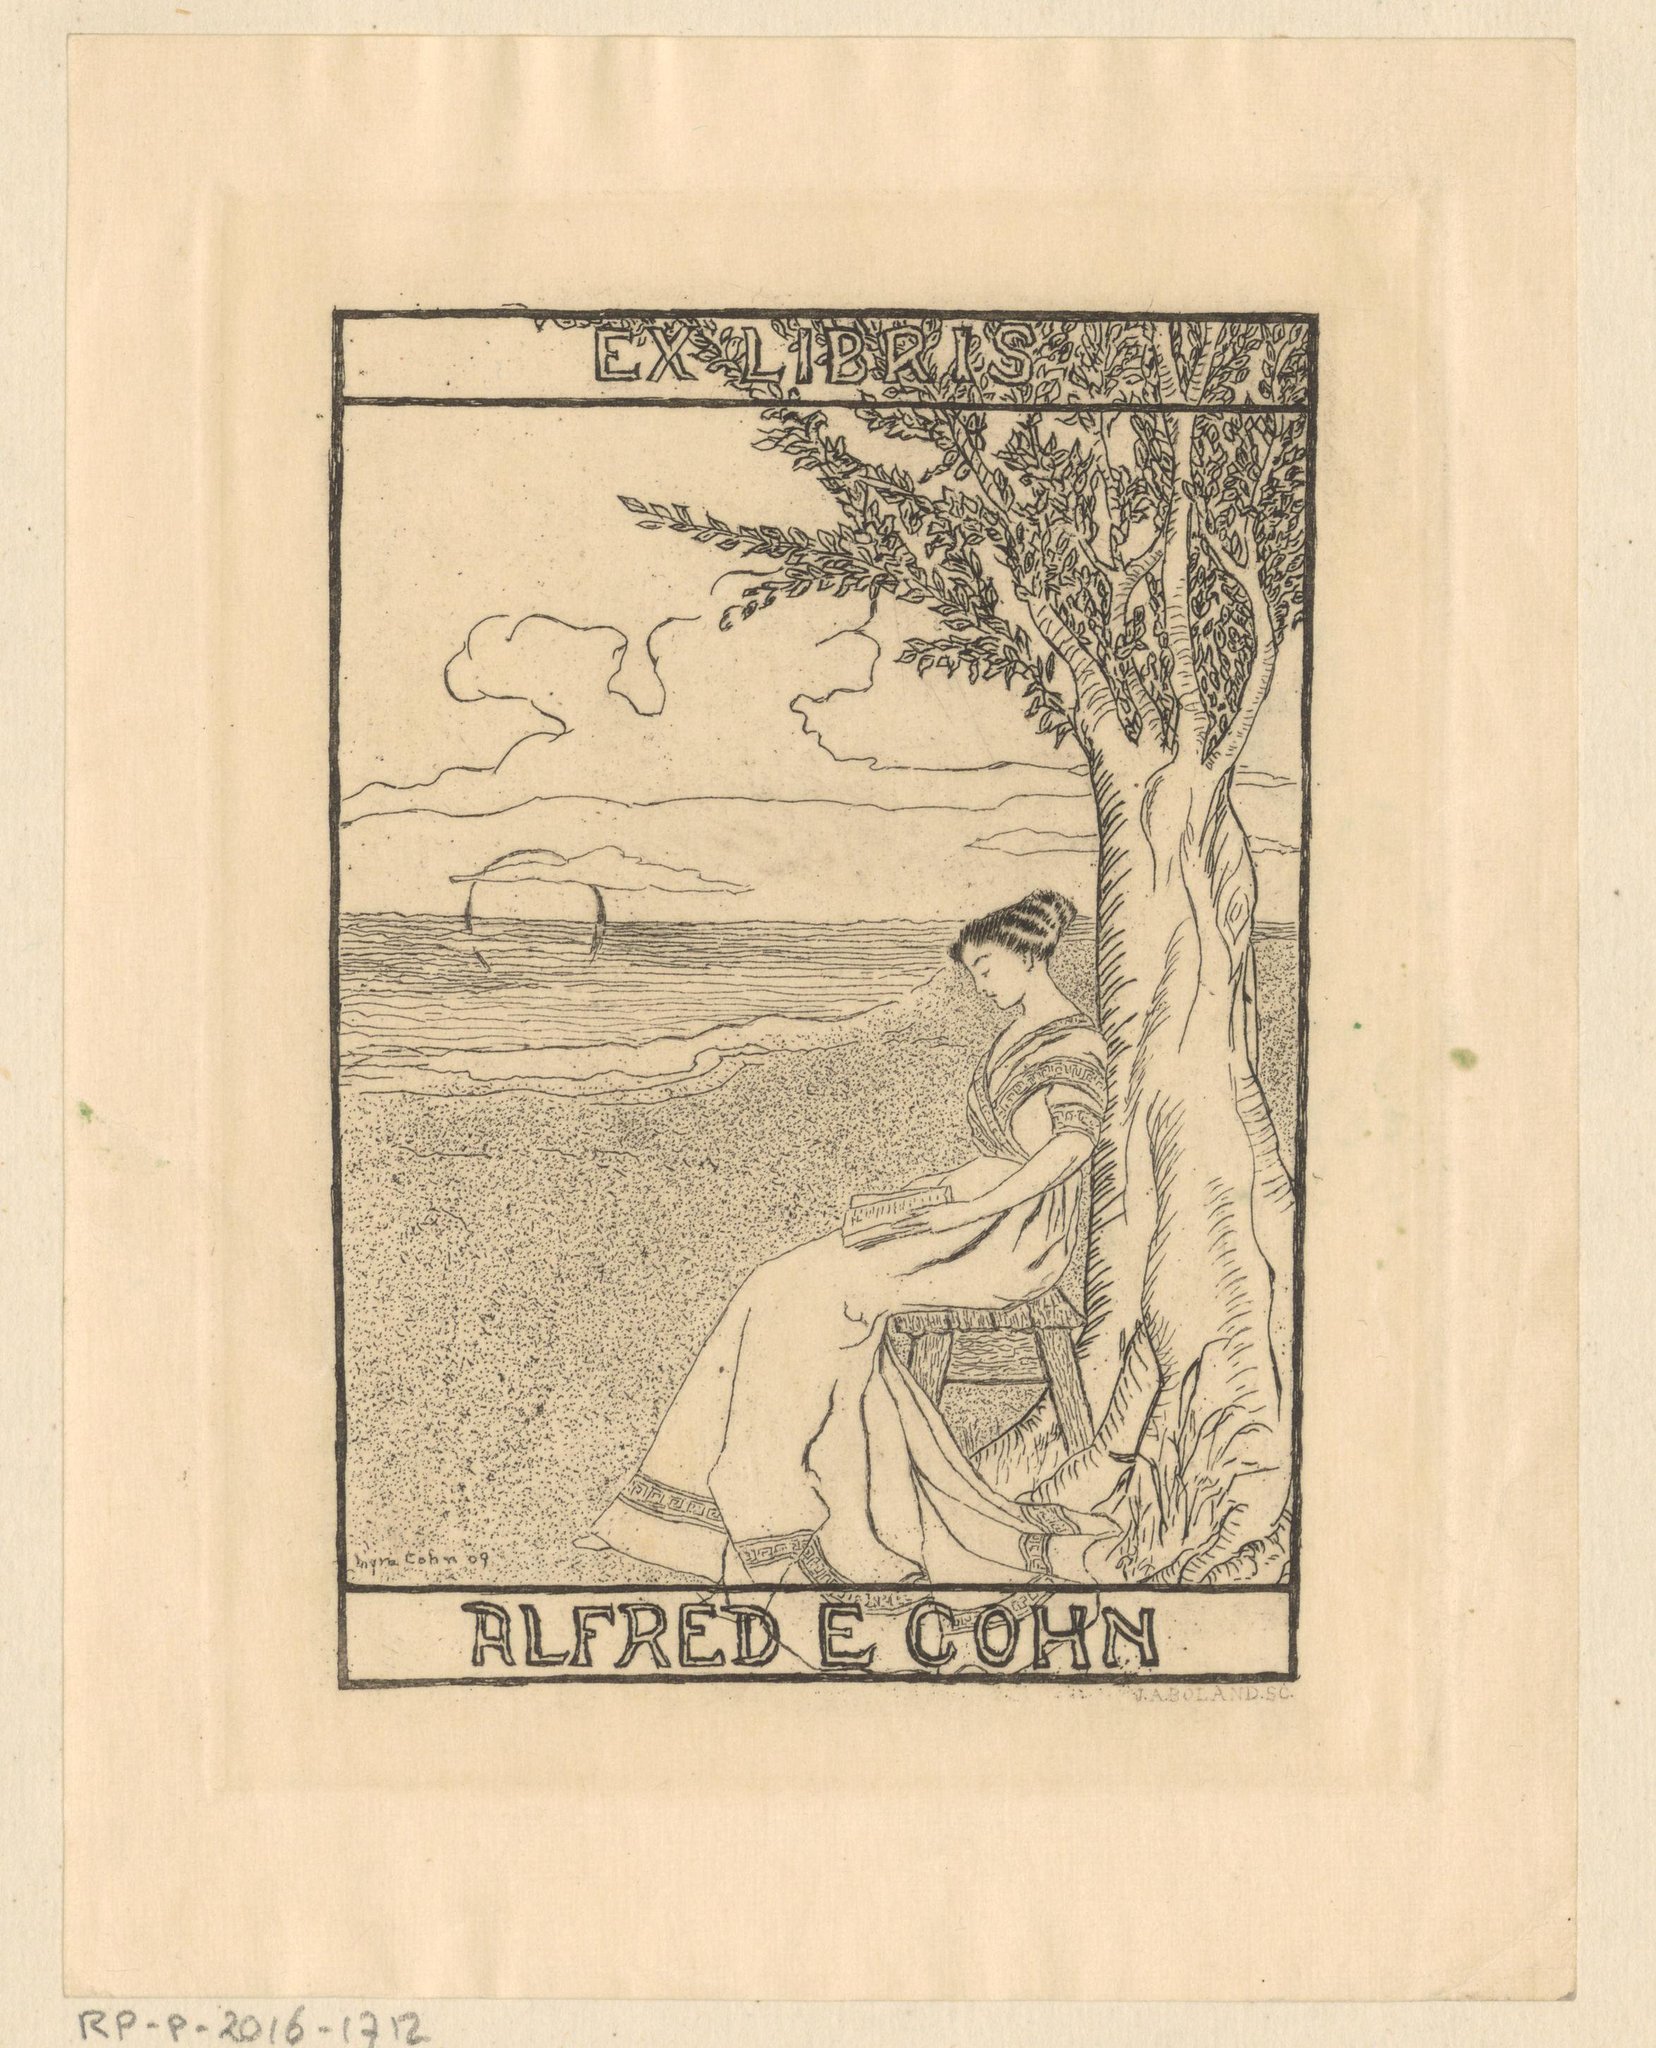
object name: bookplate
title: Ex libris van Alfred E. Cohn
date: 1909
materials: paper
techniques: etching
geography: amsterdam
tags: reading, ex-libris, sunset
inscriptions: date